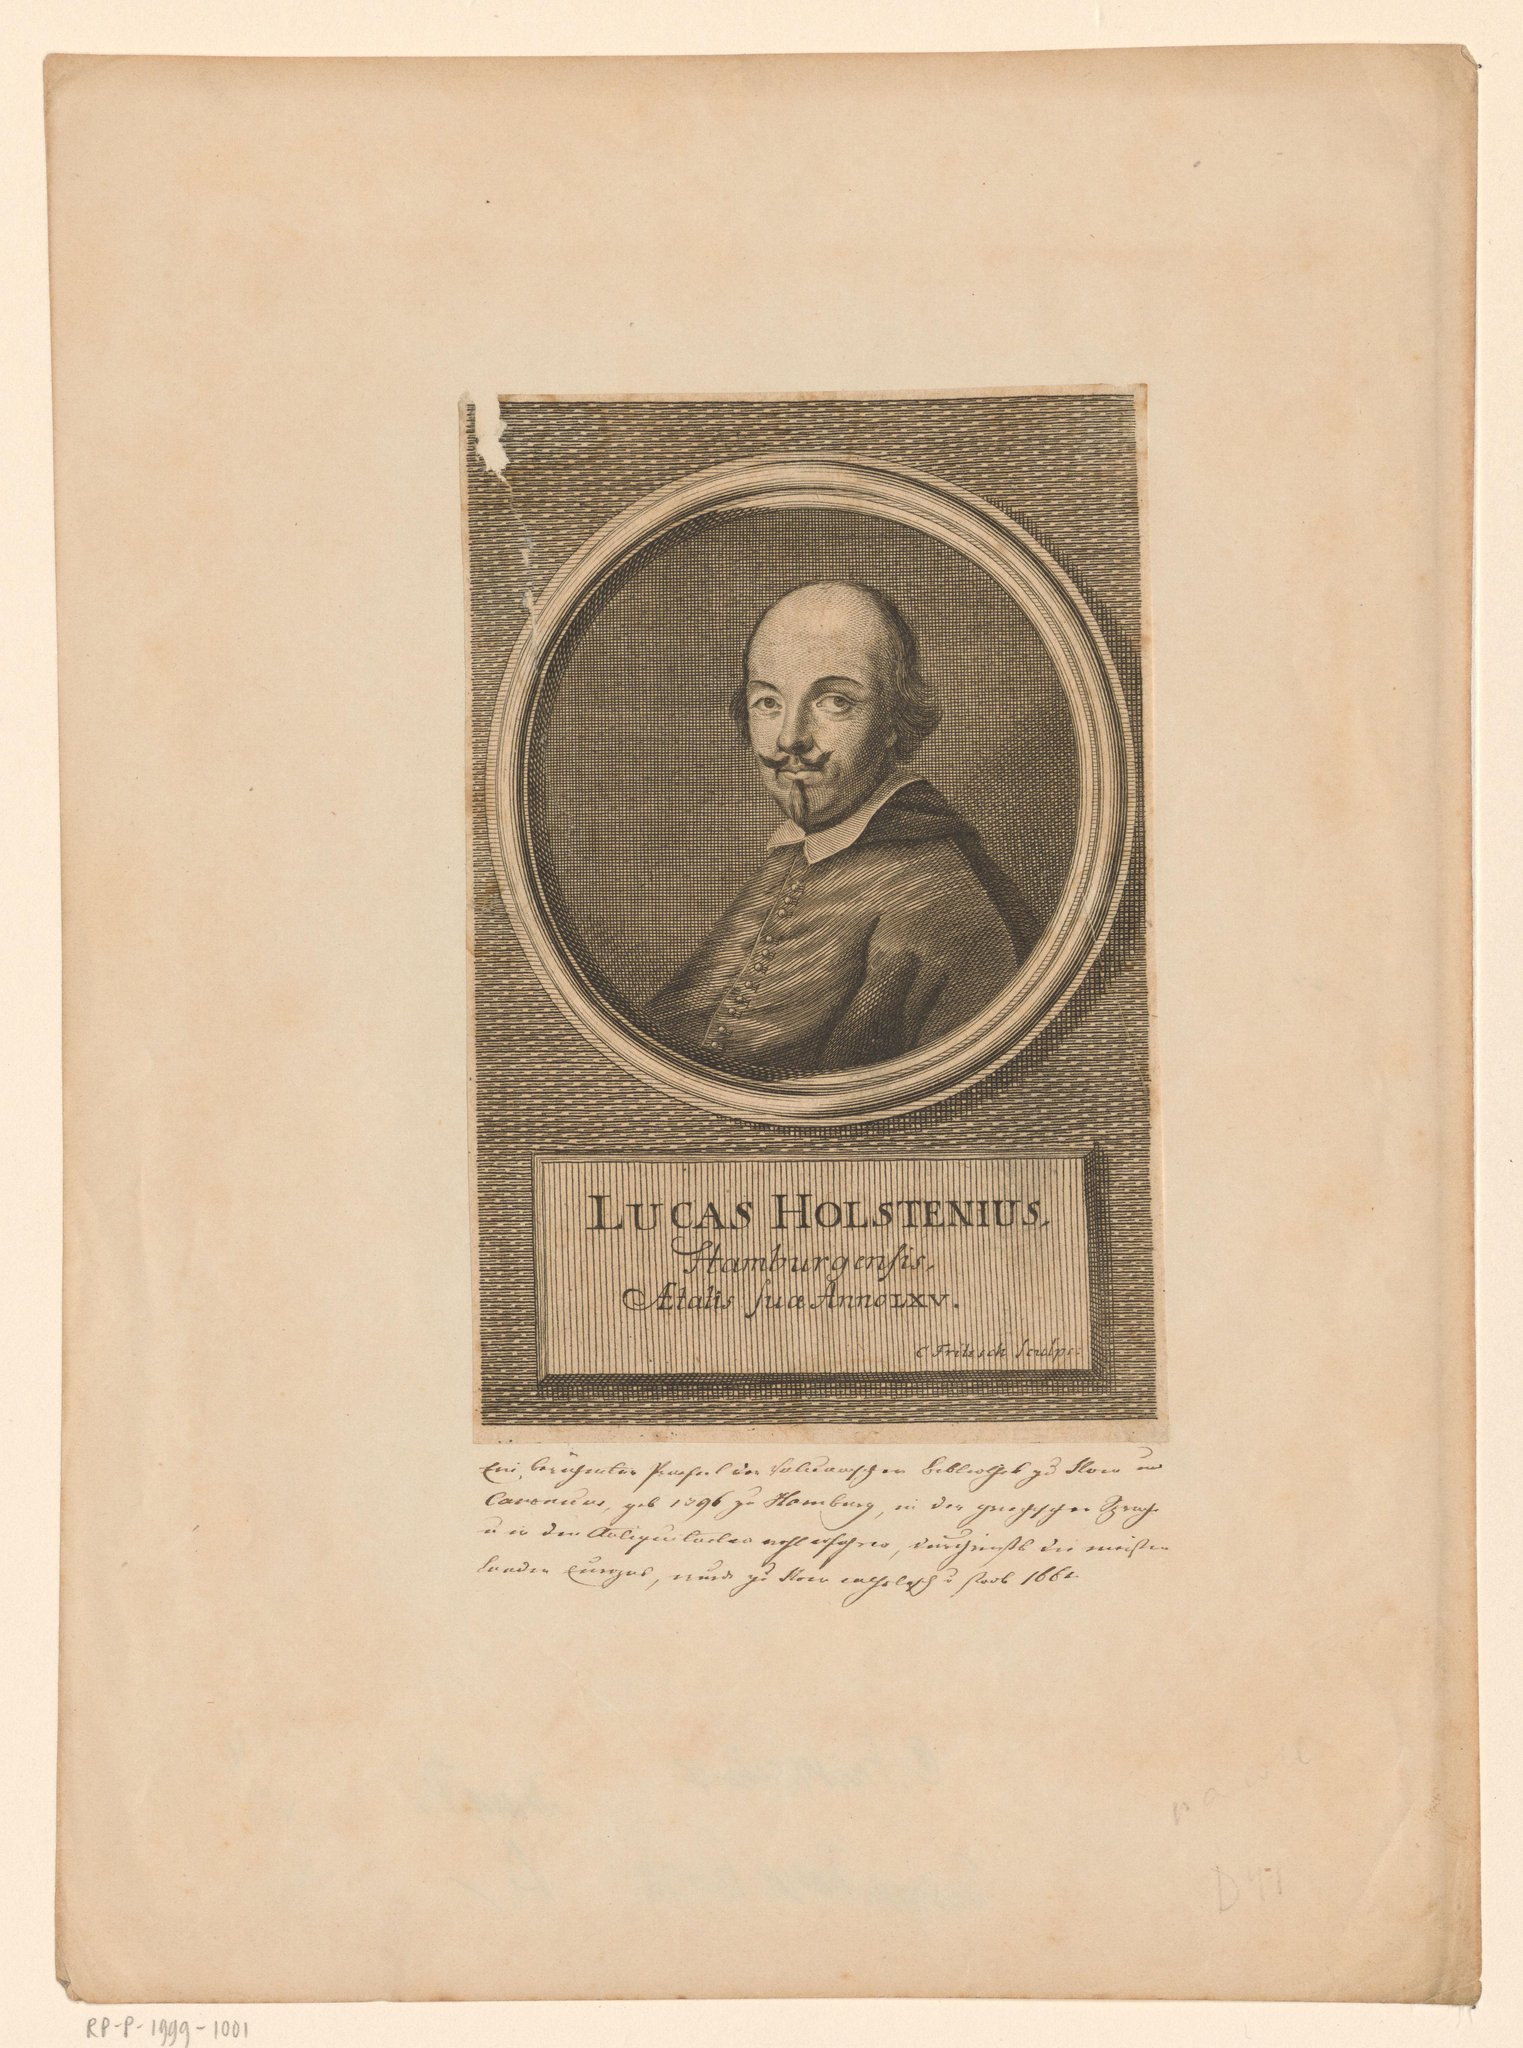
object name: print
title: Portret van Lukas Holste op 65-jarige leeftijd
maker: christian friedrich fritzsch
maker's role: print maker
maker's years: 1719-1774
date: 1729-1774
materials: paper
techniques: engraving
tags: scholar, philosopher, adult man, historical persons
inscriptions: collector's mark: Lugt 2228, collector's mark: Lugt 2760, inscription